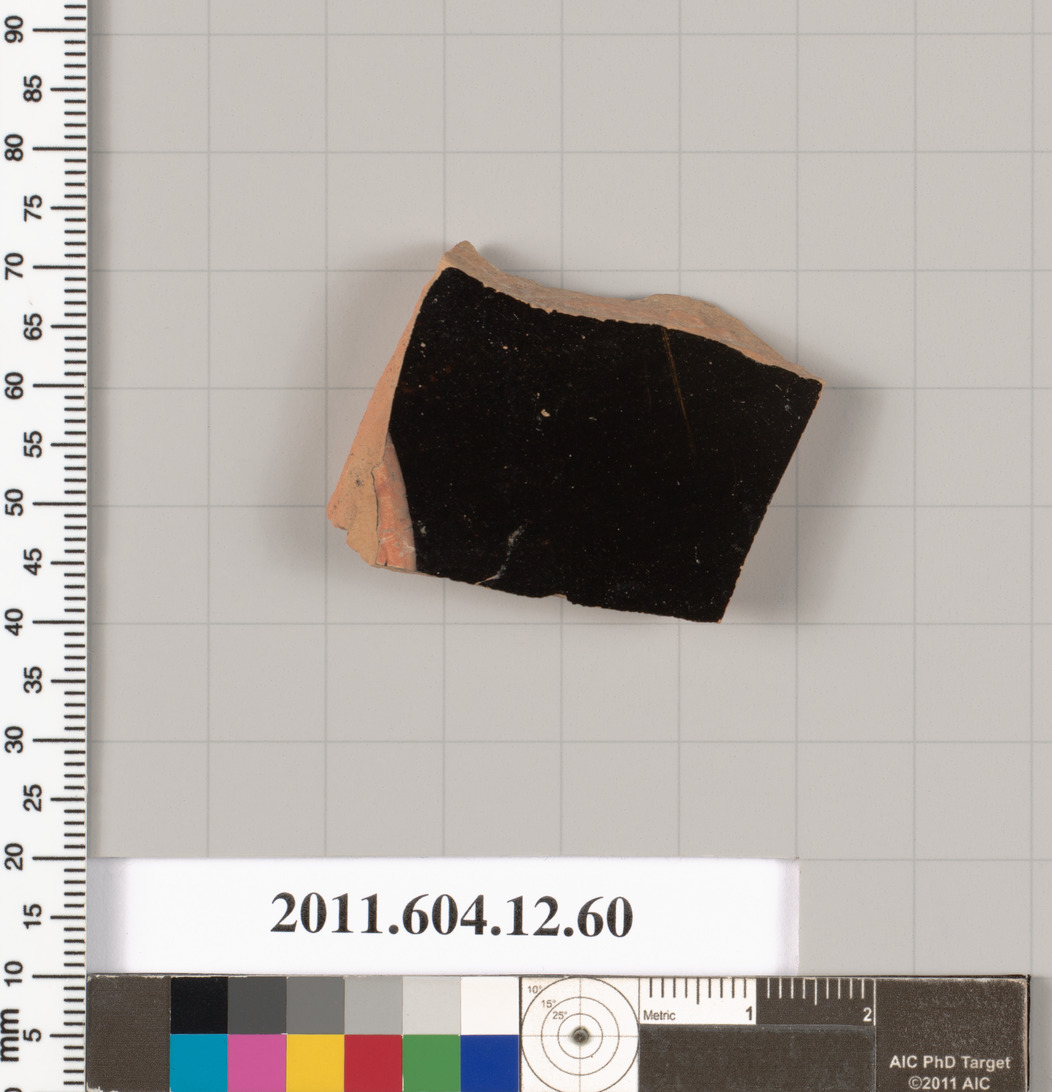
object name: undetermined open shape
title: Terracotta fragment of an open shape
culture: greek or south italian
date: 400-301 BCE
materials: terracotta